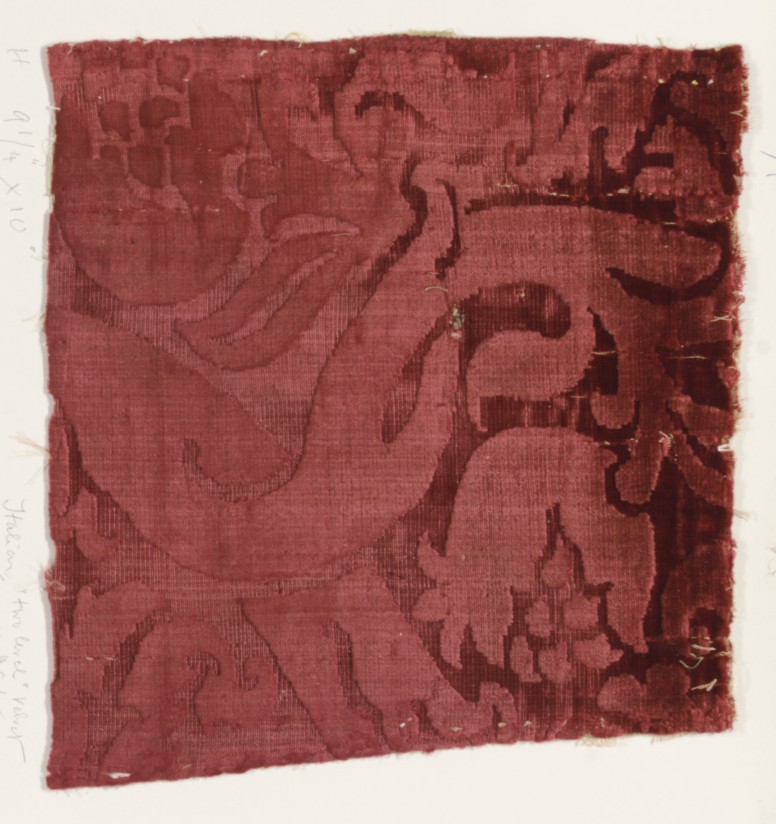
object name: fragment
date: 1601-1633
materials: silk